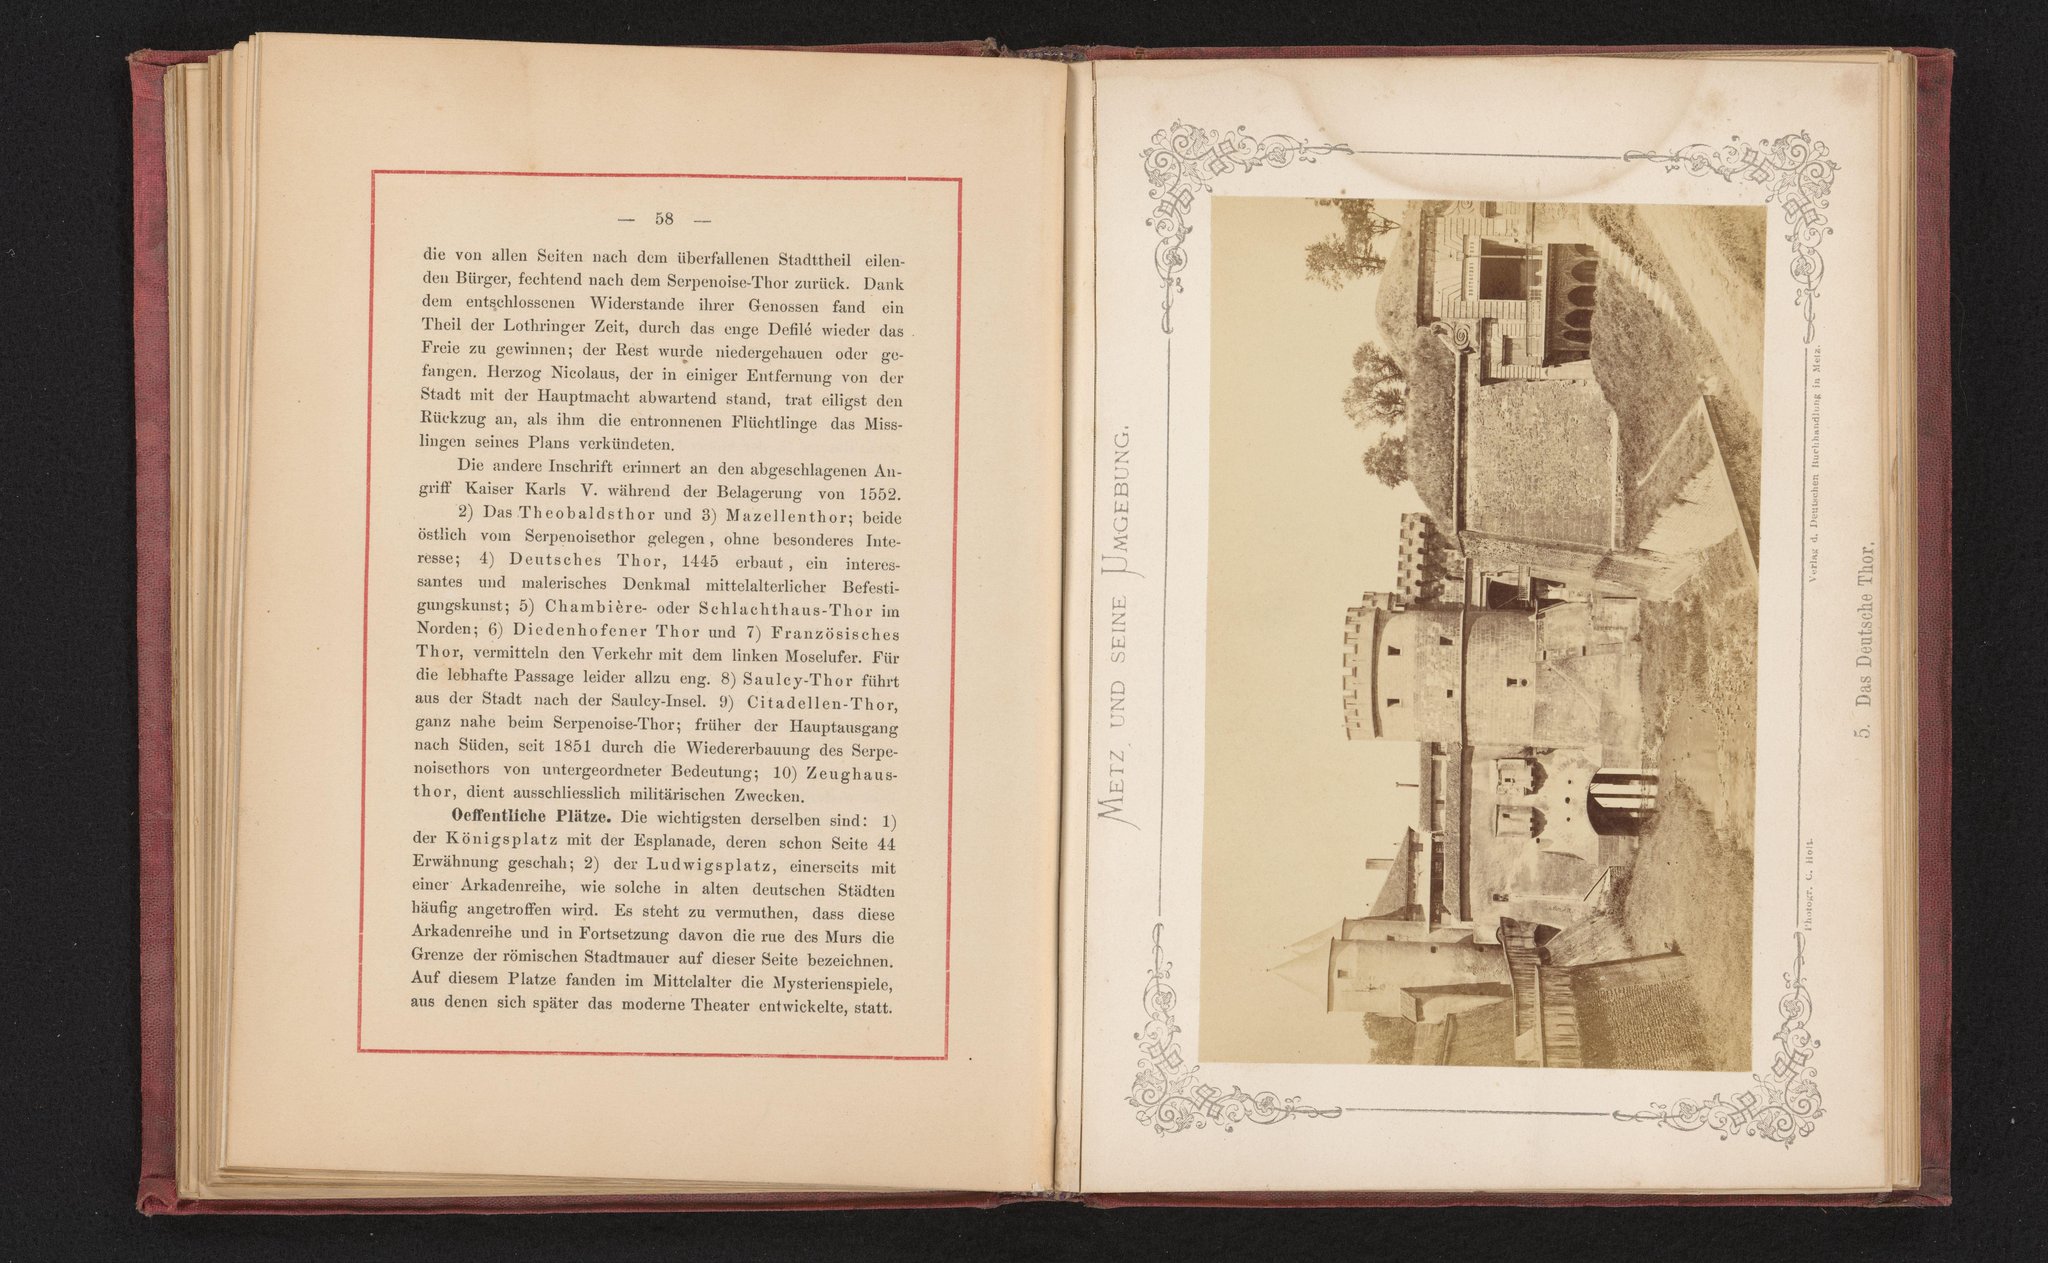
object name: page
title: Gezicht op de Porte des Allemands in Metz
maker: c. holt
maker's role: fotograaf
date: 1865-1875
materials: photographic support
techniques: albumen print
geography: metz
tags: city-gate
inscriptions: number: ‘5.’